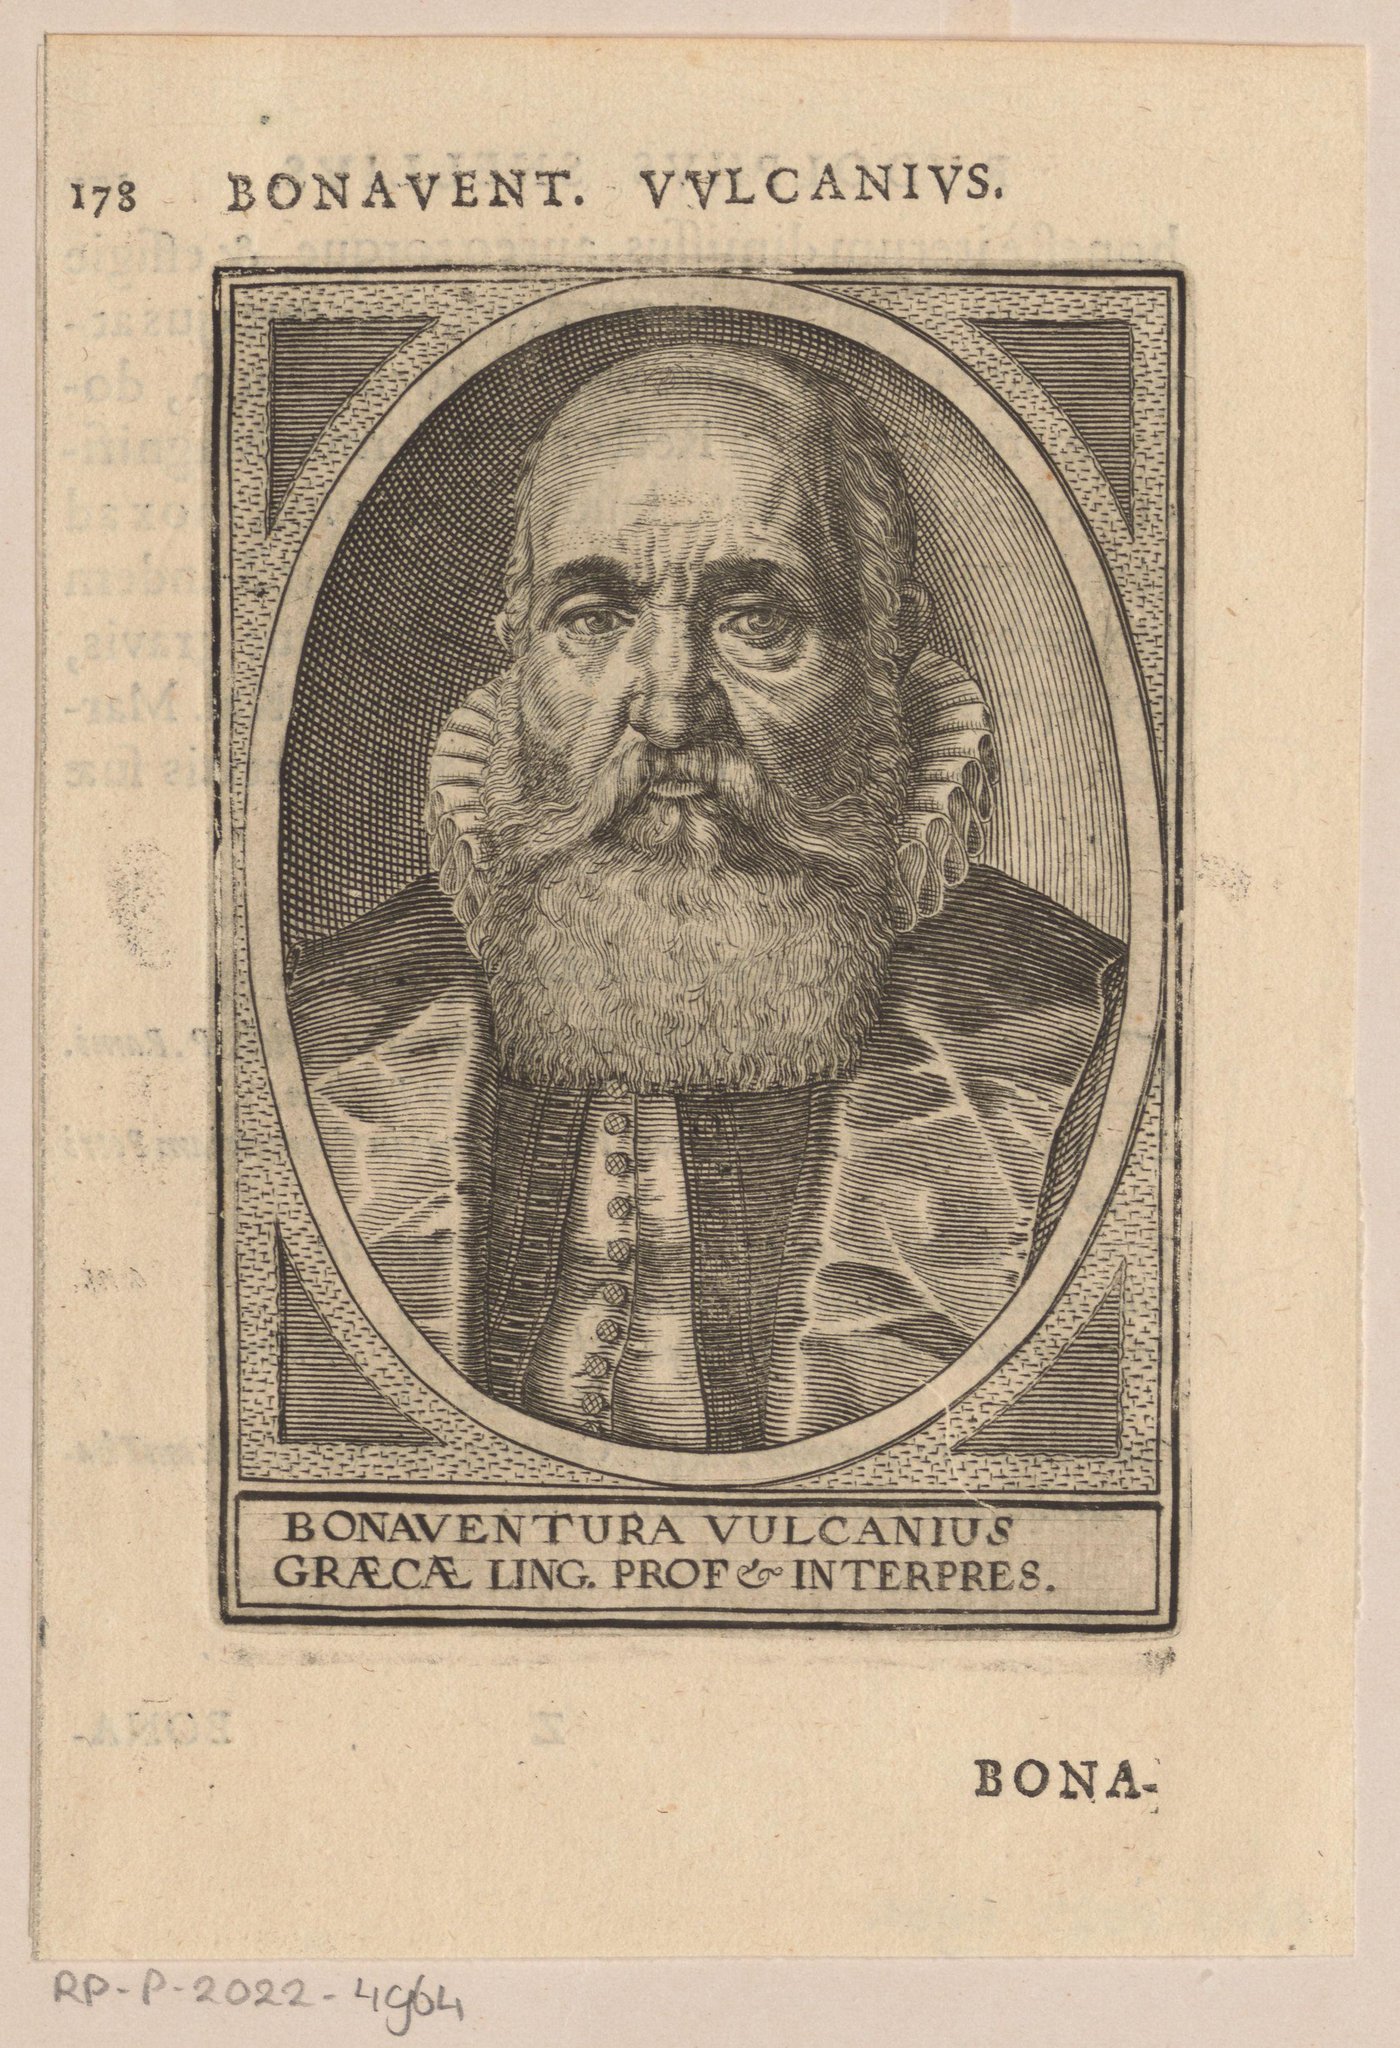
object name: print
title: Portret van Bonaventura Vulcanius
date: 1614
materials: paper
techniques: engraving, letterpress printing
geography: northern netherlands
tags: bruges, leiden, bonaventura vulcanius, scholar, philosopher, historical persons, portrait of a writer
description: Prent uit: Illustrium Hollandiae & Westfrisiae ordinum alma academia Leidensis. Leiden: Jacob Marcus en Joost van Colster, 1614.